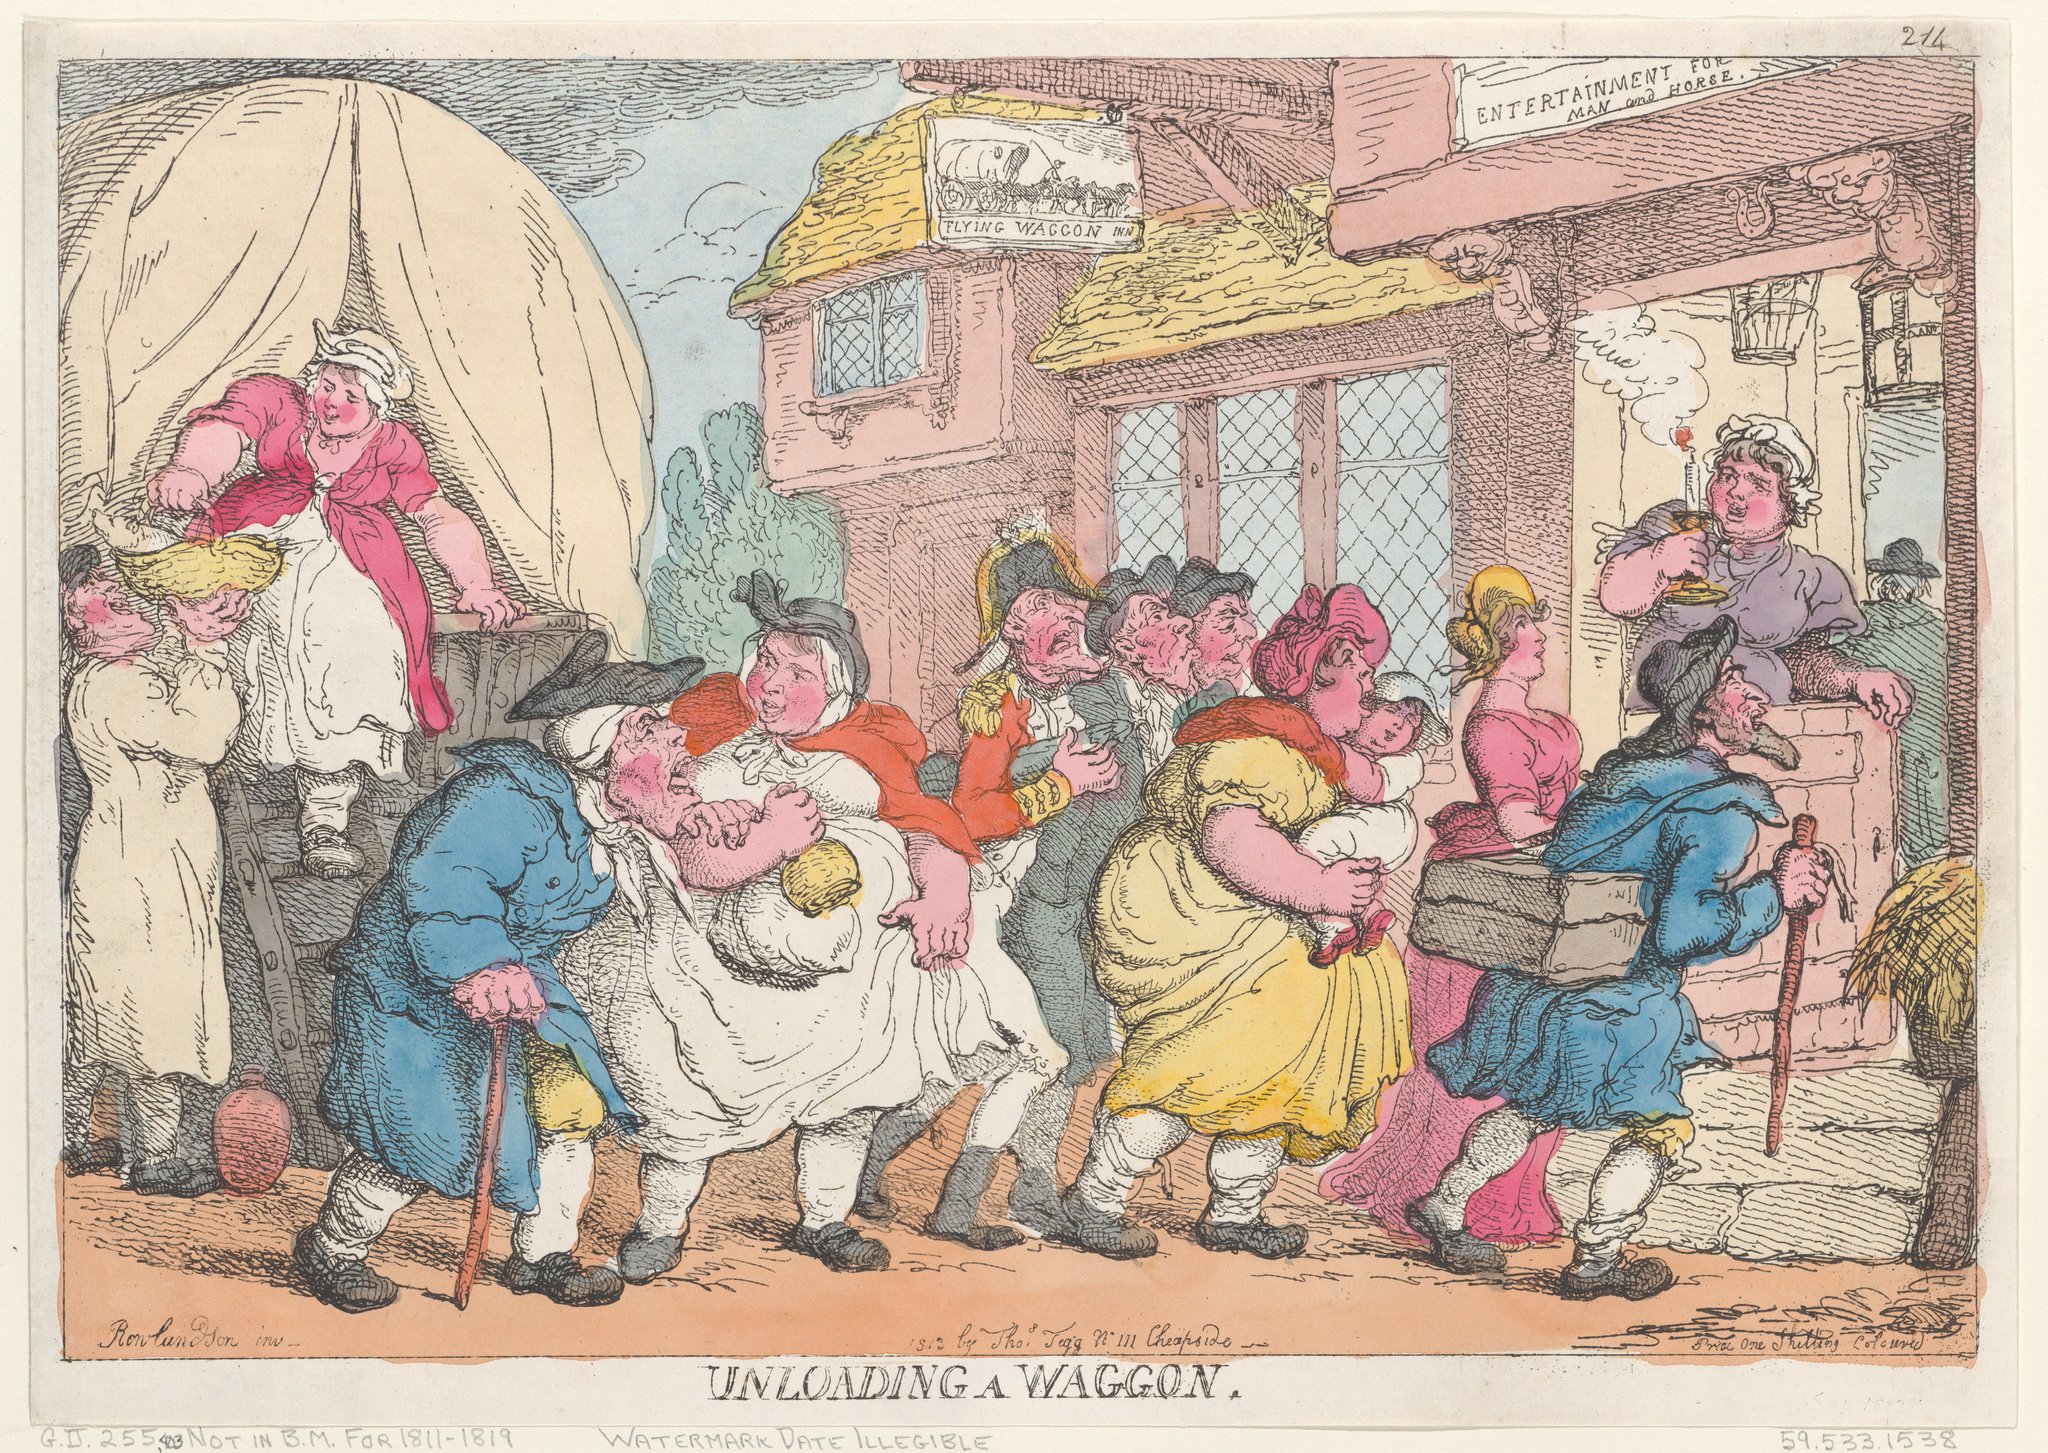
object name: print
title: A Doleful Disaster, or Miss Fubby Fatarmin's Wig Caught Fire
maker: thomas rowlandson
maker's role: artist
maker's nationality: british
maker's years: 1757-1827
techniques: etching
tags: satire,men,women